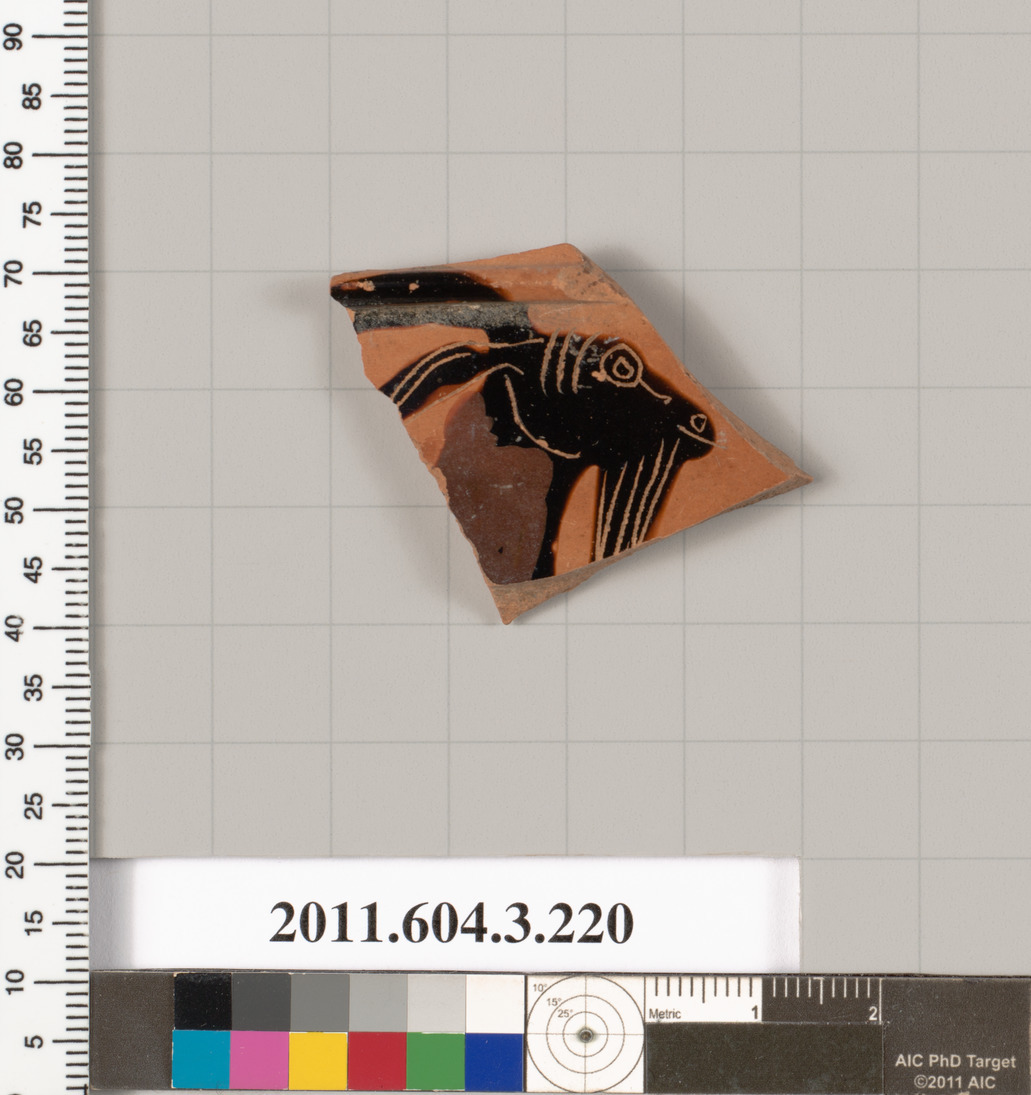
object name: neck amphora fragment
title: Terracotta fragment of a neck-amphora of Nicosthenic shape (jar)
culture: greek, attic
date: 525-501 BCE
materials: terracotta